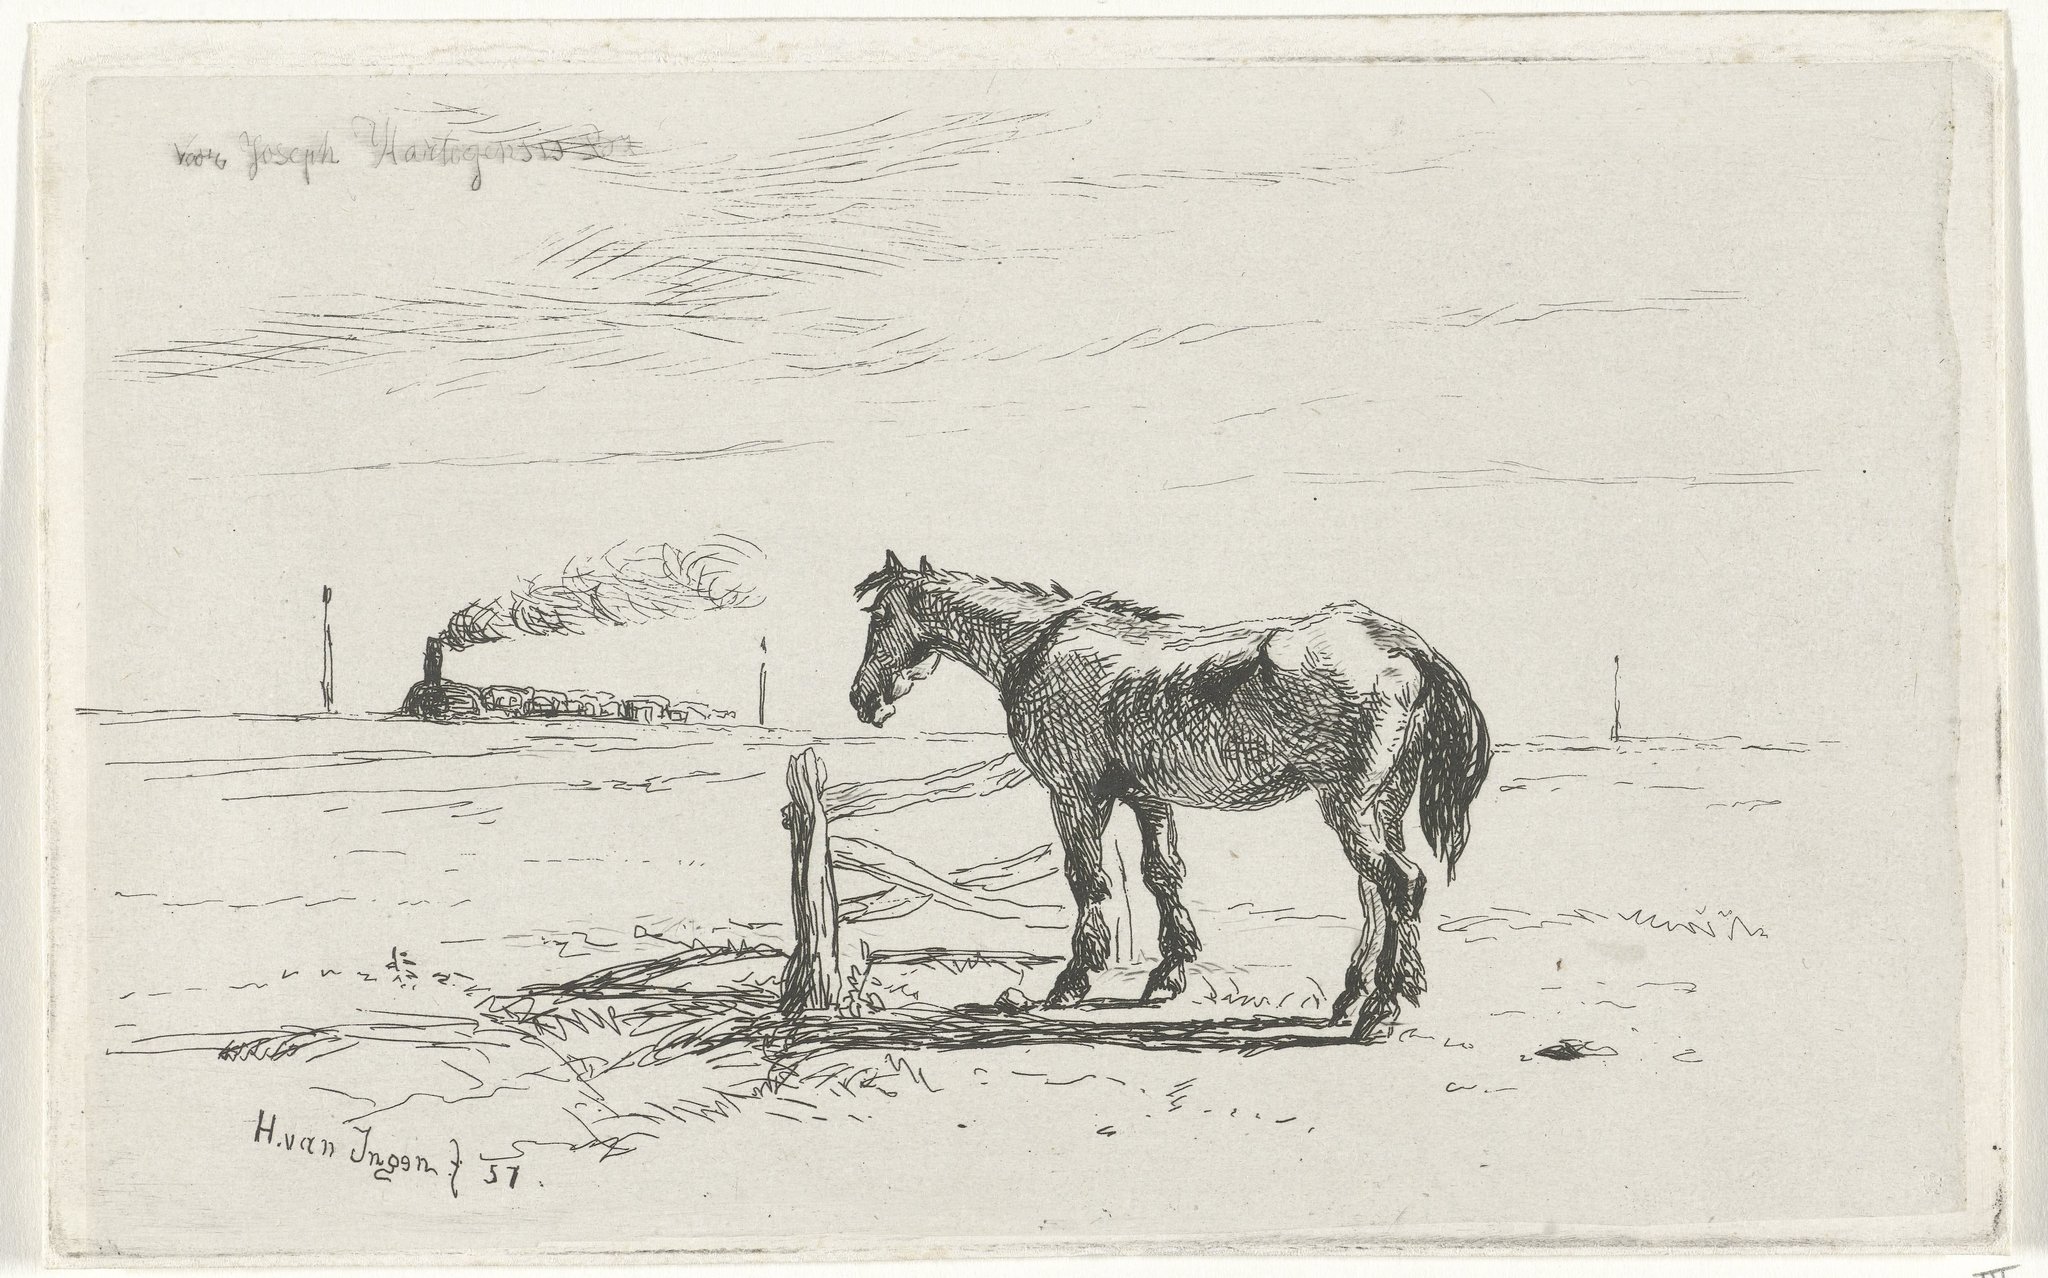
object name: print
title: Paard in een weiland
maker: joseph hartogensis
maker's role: painter, print maker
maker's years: 1822-1865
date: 1857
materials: paper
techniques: etching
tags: horses and kindred animals, steam locomotive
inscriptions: collector's mark: Lugt 2228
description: Paard bij een hek in een weiland. Aan de horizon rijdt een stoomtrein.